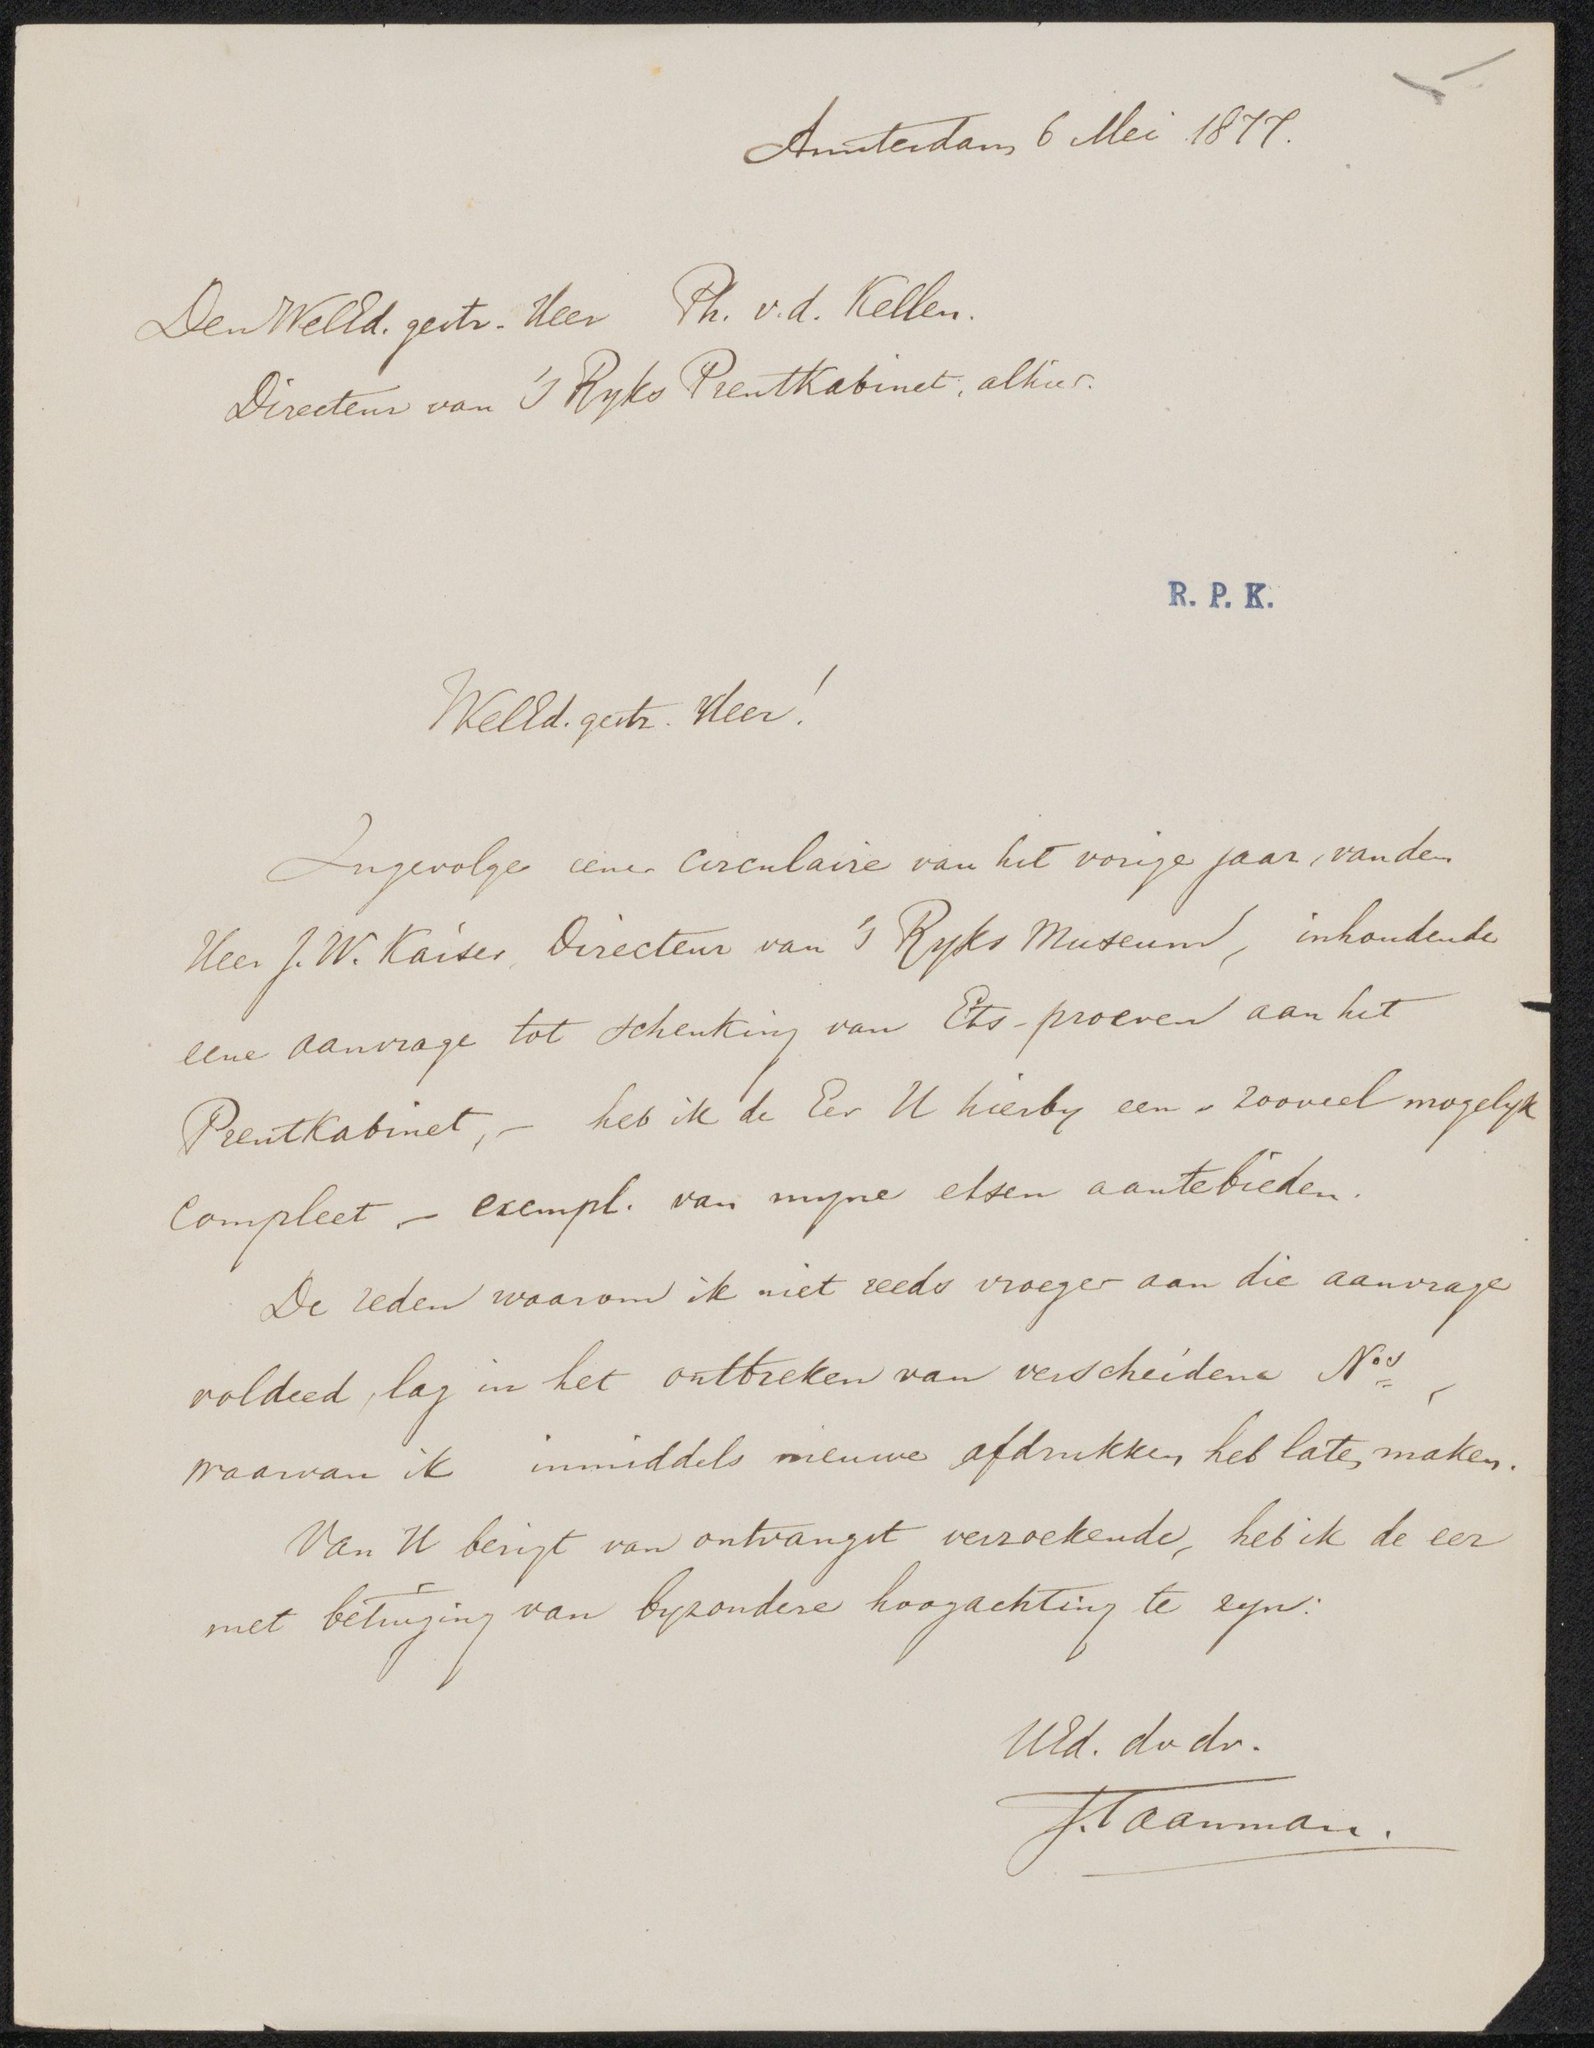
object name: letter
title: Brief aan Johan Philip van der Kellen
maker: jacob taanman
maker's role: draughtsman, print maker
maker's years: 1836-1923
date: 1877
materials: ink, paper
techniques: pen, writing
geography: amsterdam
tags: print room, print maker, draughtsman, johan philip van der kellen, the graphic arts, art collecting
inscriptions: collector's mark: Lugt 2233